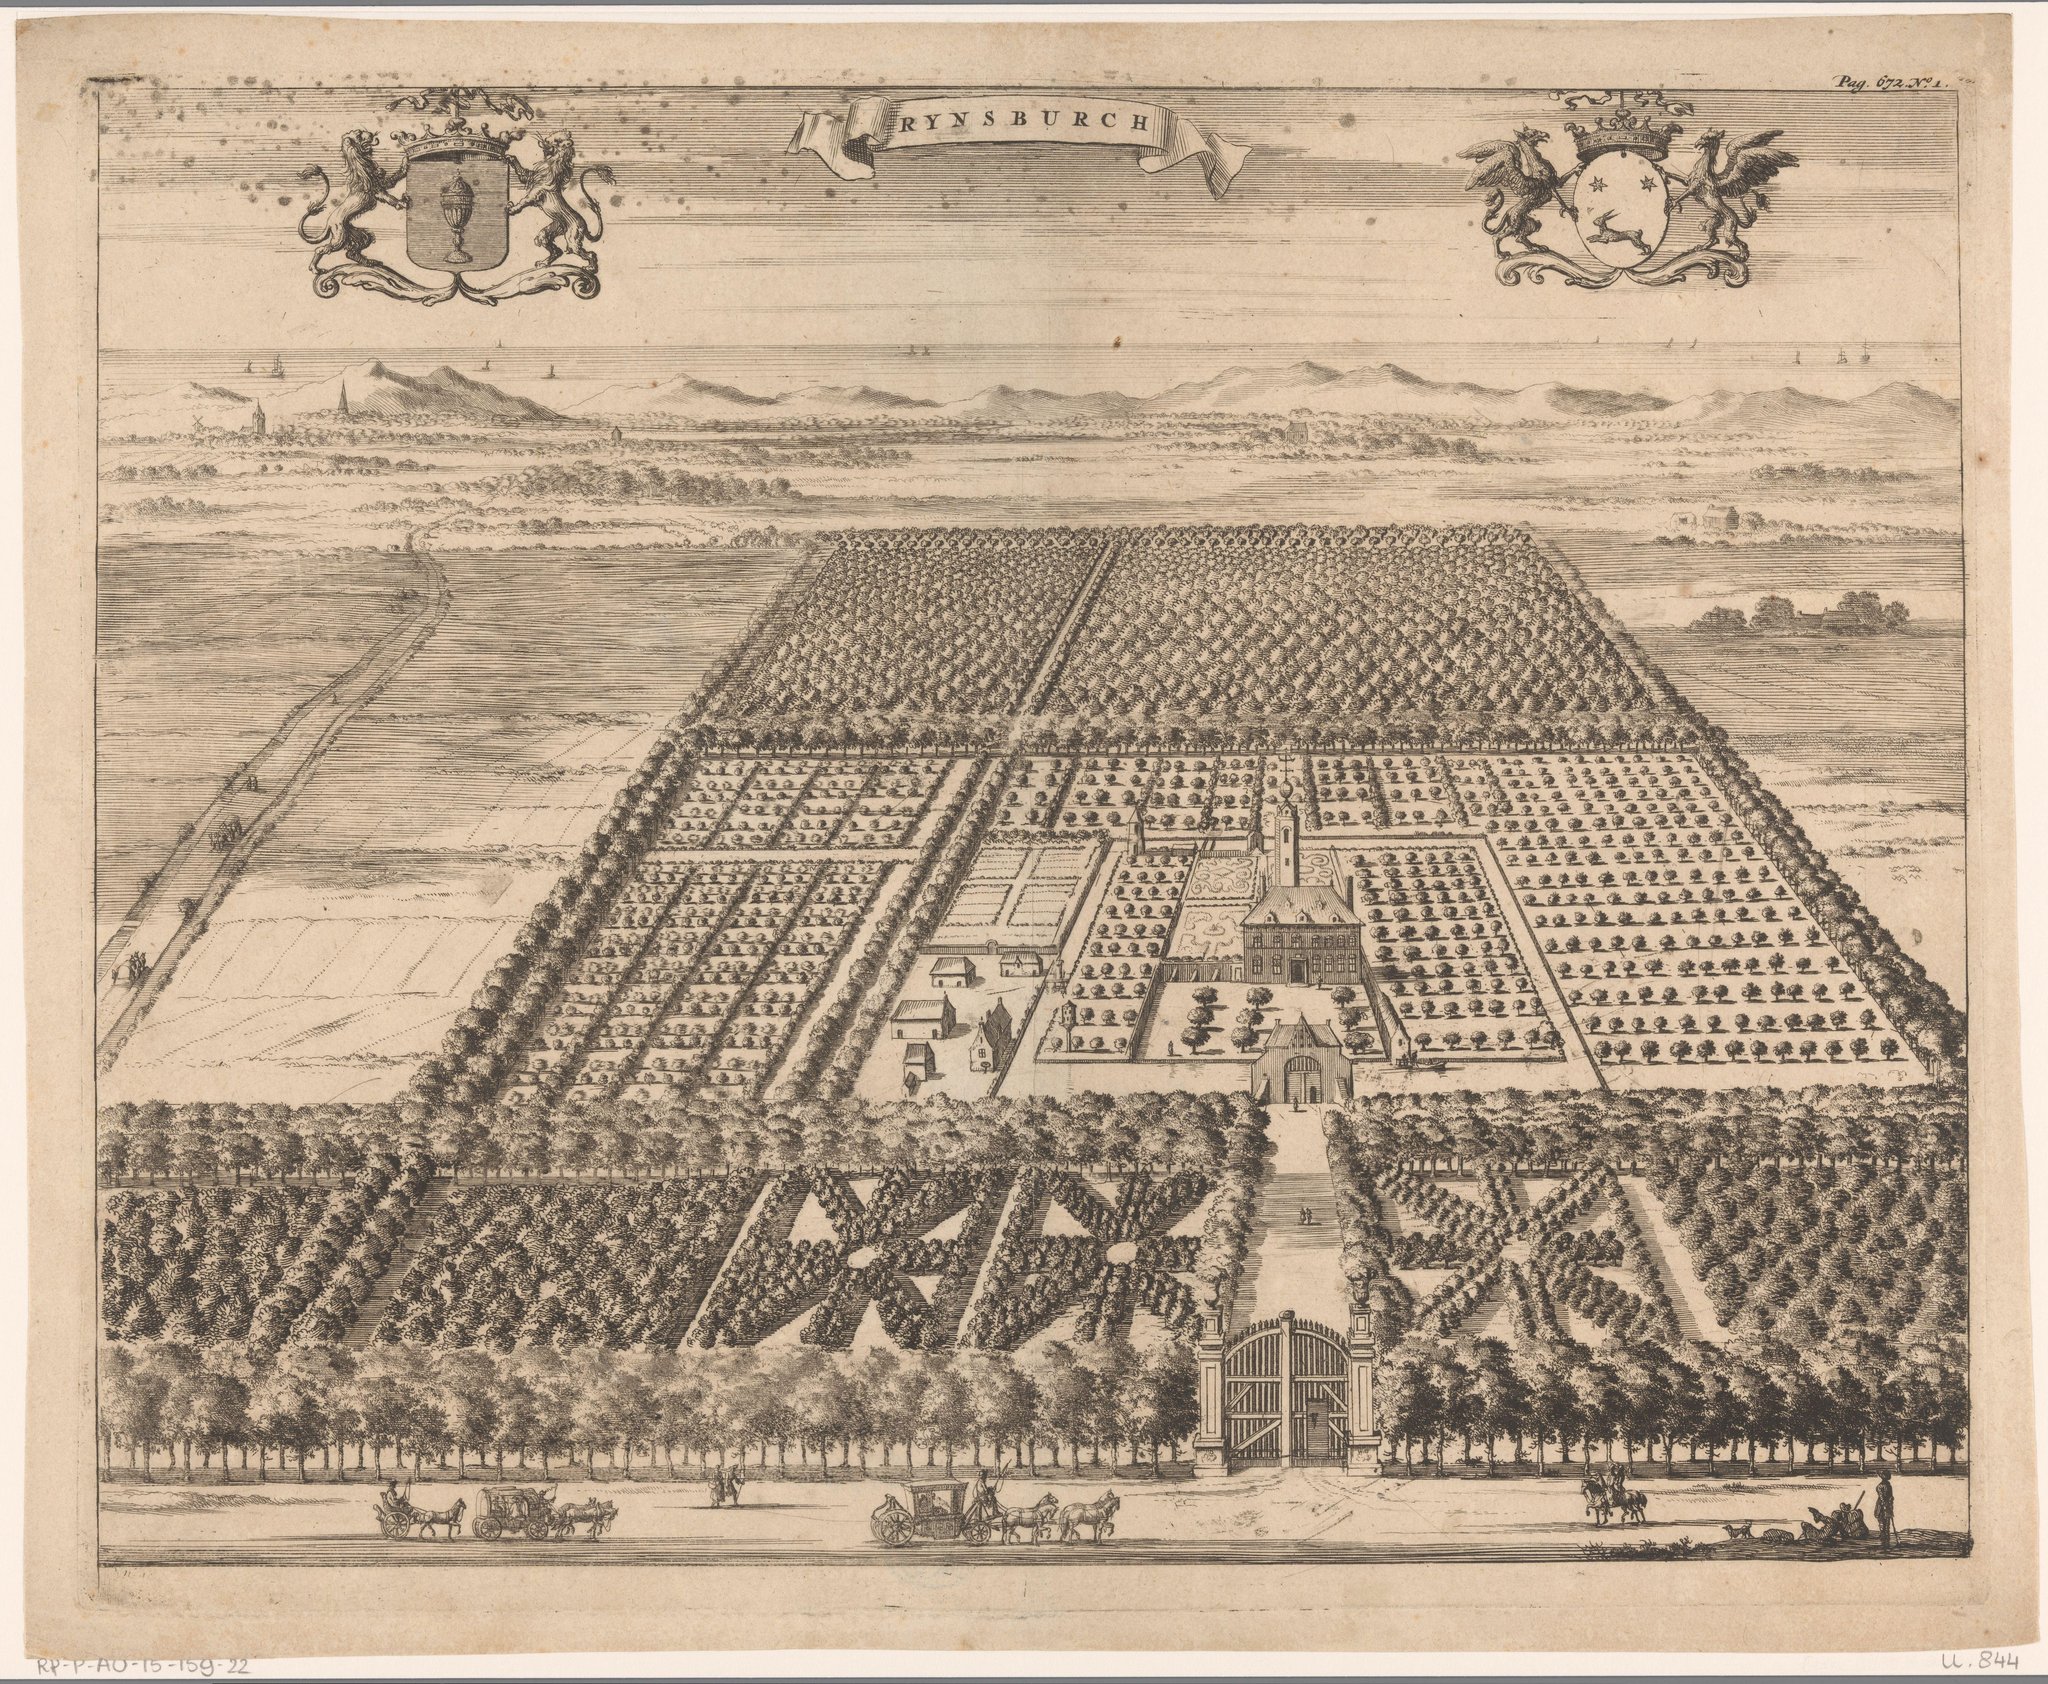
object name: book illustration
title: Rynsburch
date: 1696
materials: paper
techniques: engraving, etching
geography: amsterdam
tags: dune coast, french or architectonic garden; formal garden, gate, entrance, orchard, armorial bearing, heraldry, country-house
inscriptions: collector's mark: Lugt 195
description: Gezicht op de buitenplaats Rijnsburg bij Oostkapelle, in vogelvluchtperspectief. Rechts van het midden het buitenhuis met daaromheen de tuinen en boomgaarden. Op de achtergrond de duinen en zee. Linksboven het wapen van eigenaar Jacob Godin, in het midden een banderol met de titel, rechtsboven het wapen van zijn echtgenote Catharina de Haze. Rechtsboven gemerkt: Pag. 672. No. 1.